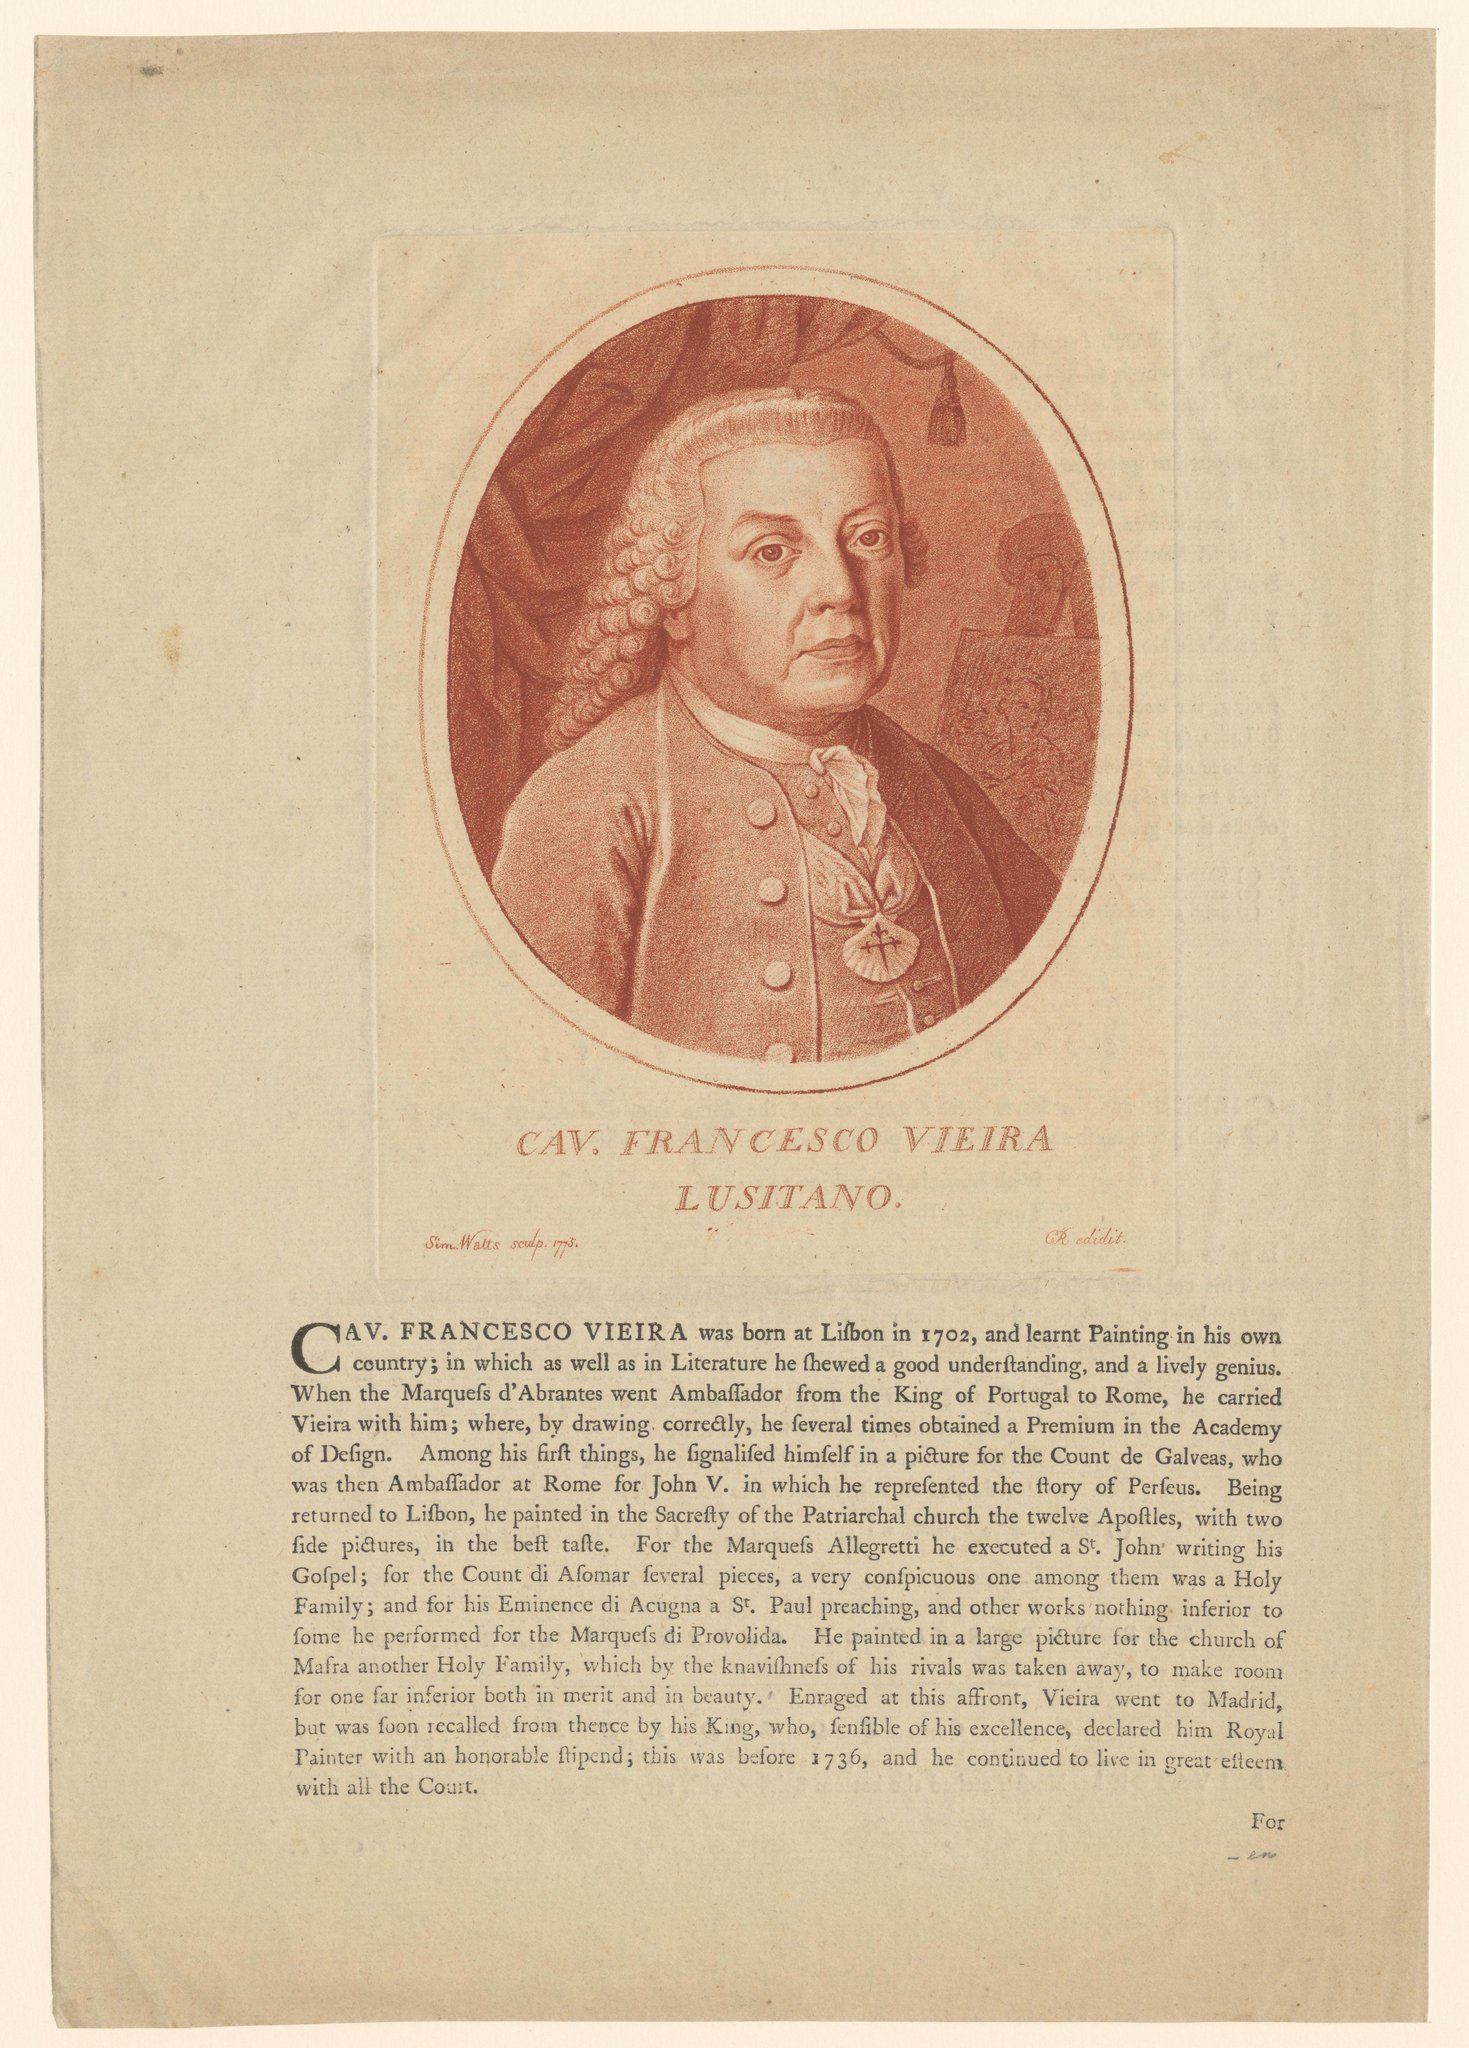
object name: print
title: Portret van Vieira Lusitano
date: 1775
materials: paper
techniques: letterpress printing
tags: painter, draughtsman, historical persons, portrait, self-portrait of artist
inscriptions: collector's mark: Lugt 2228